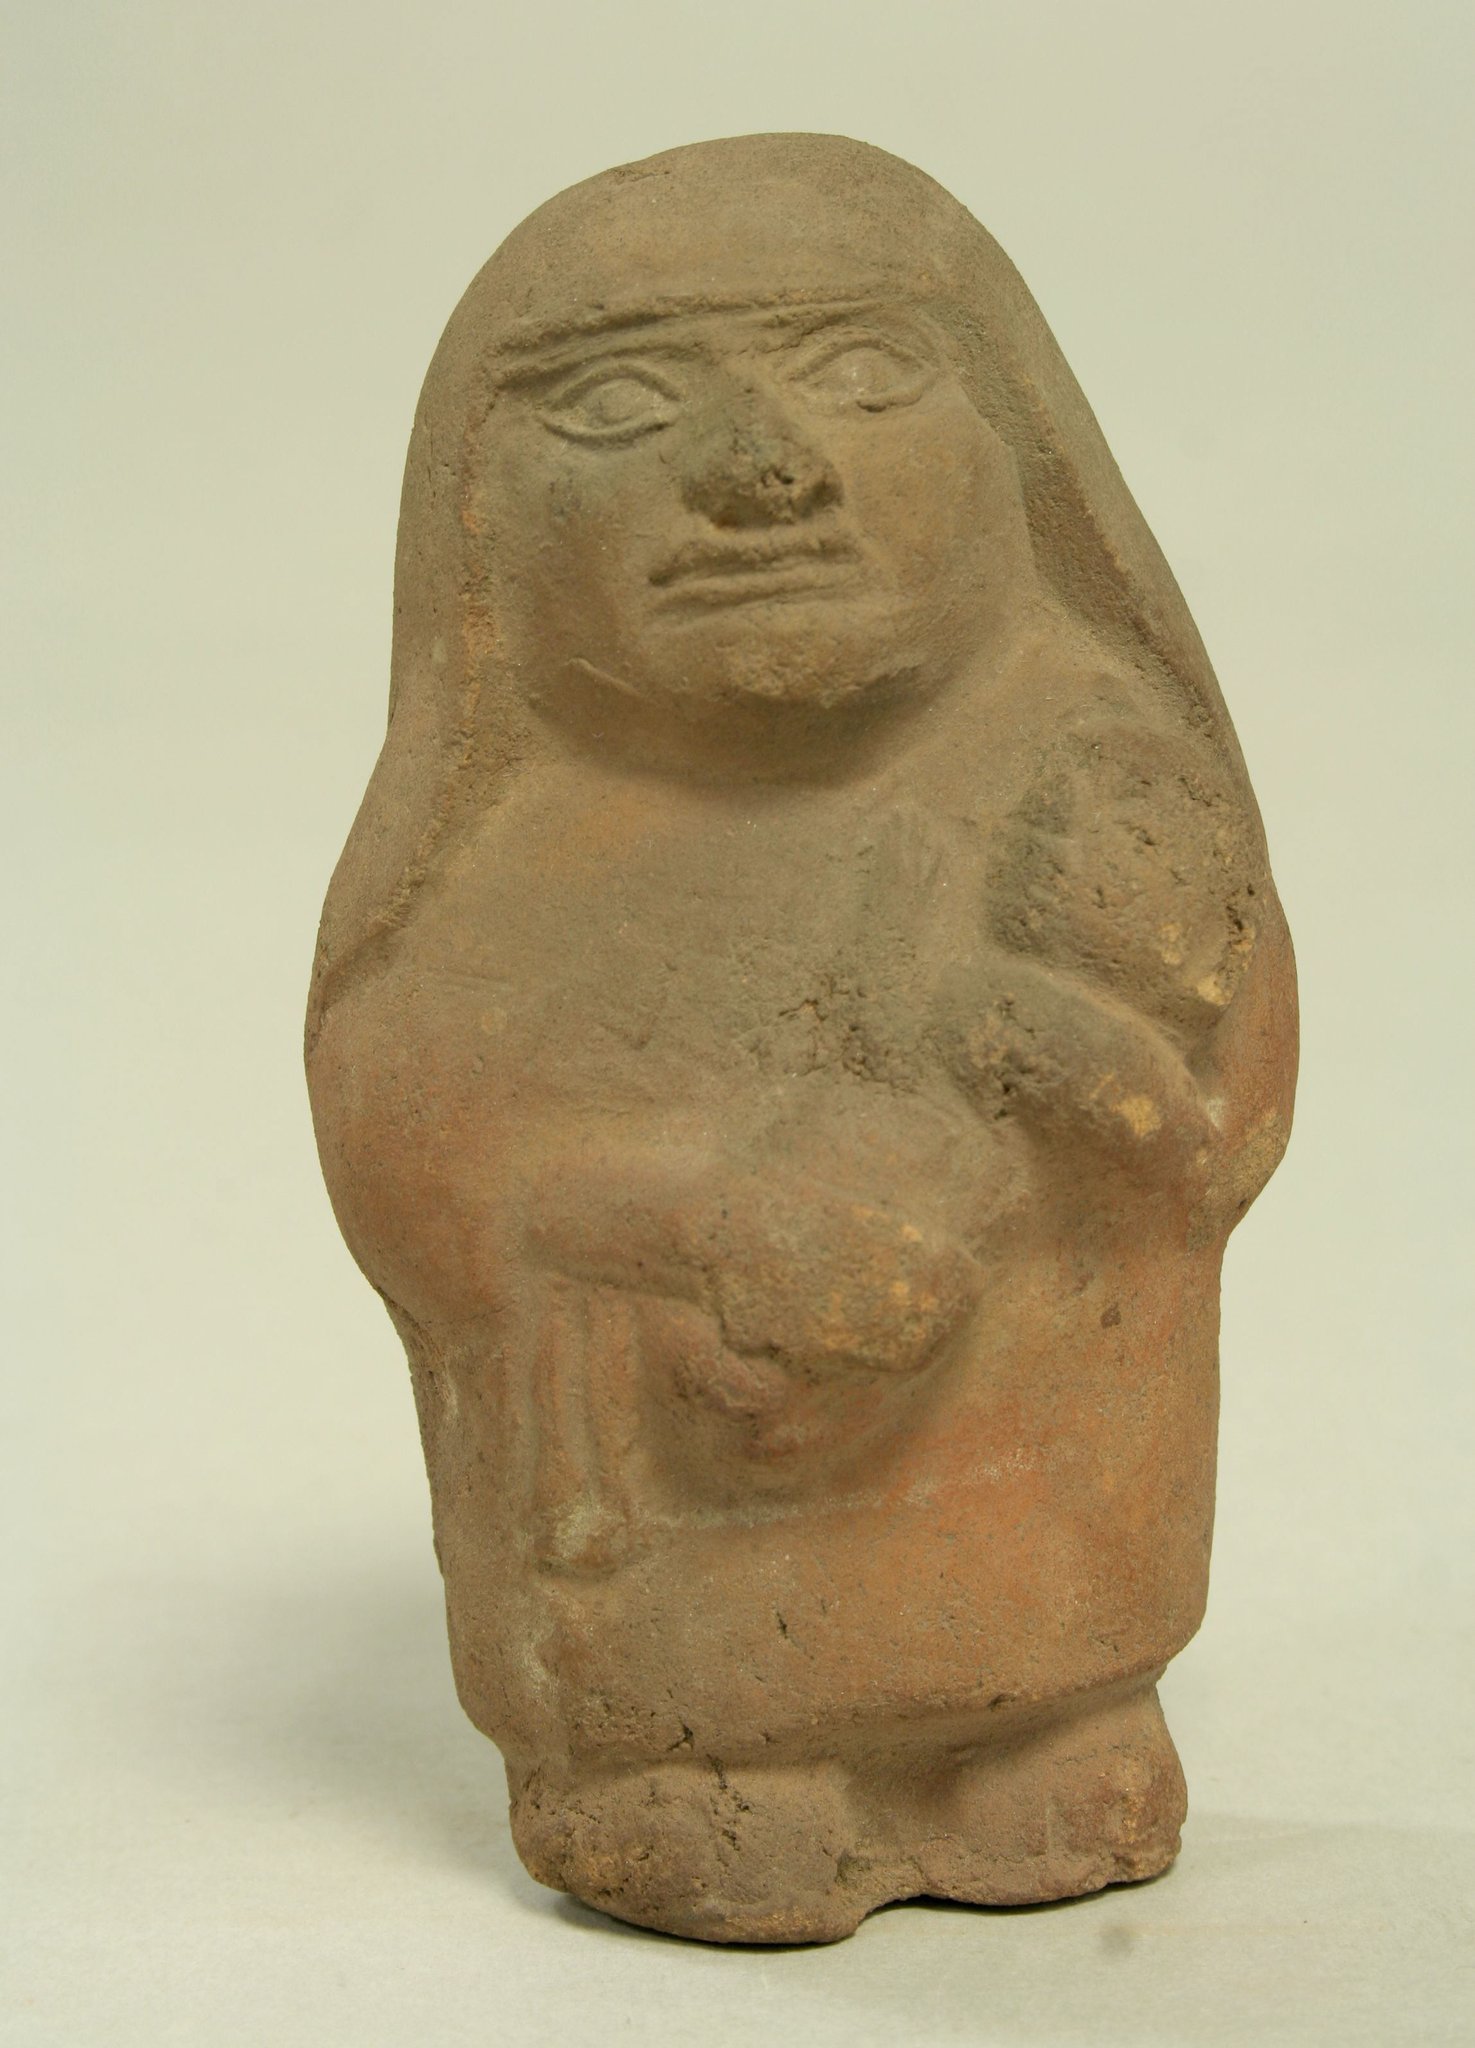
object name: figure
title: Standing Ceramic Figure with Child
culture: moche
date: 201-500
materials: ceramic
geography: peru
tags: women